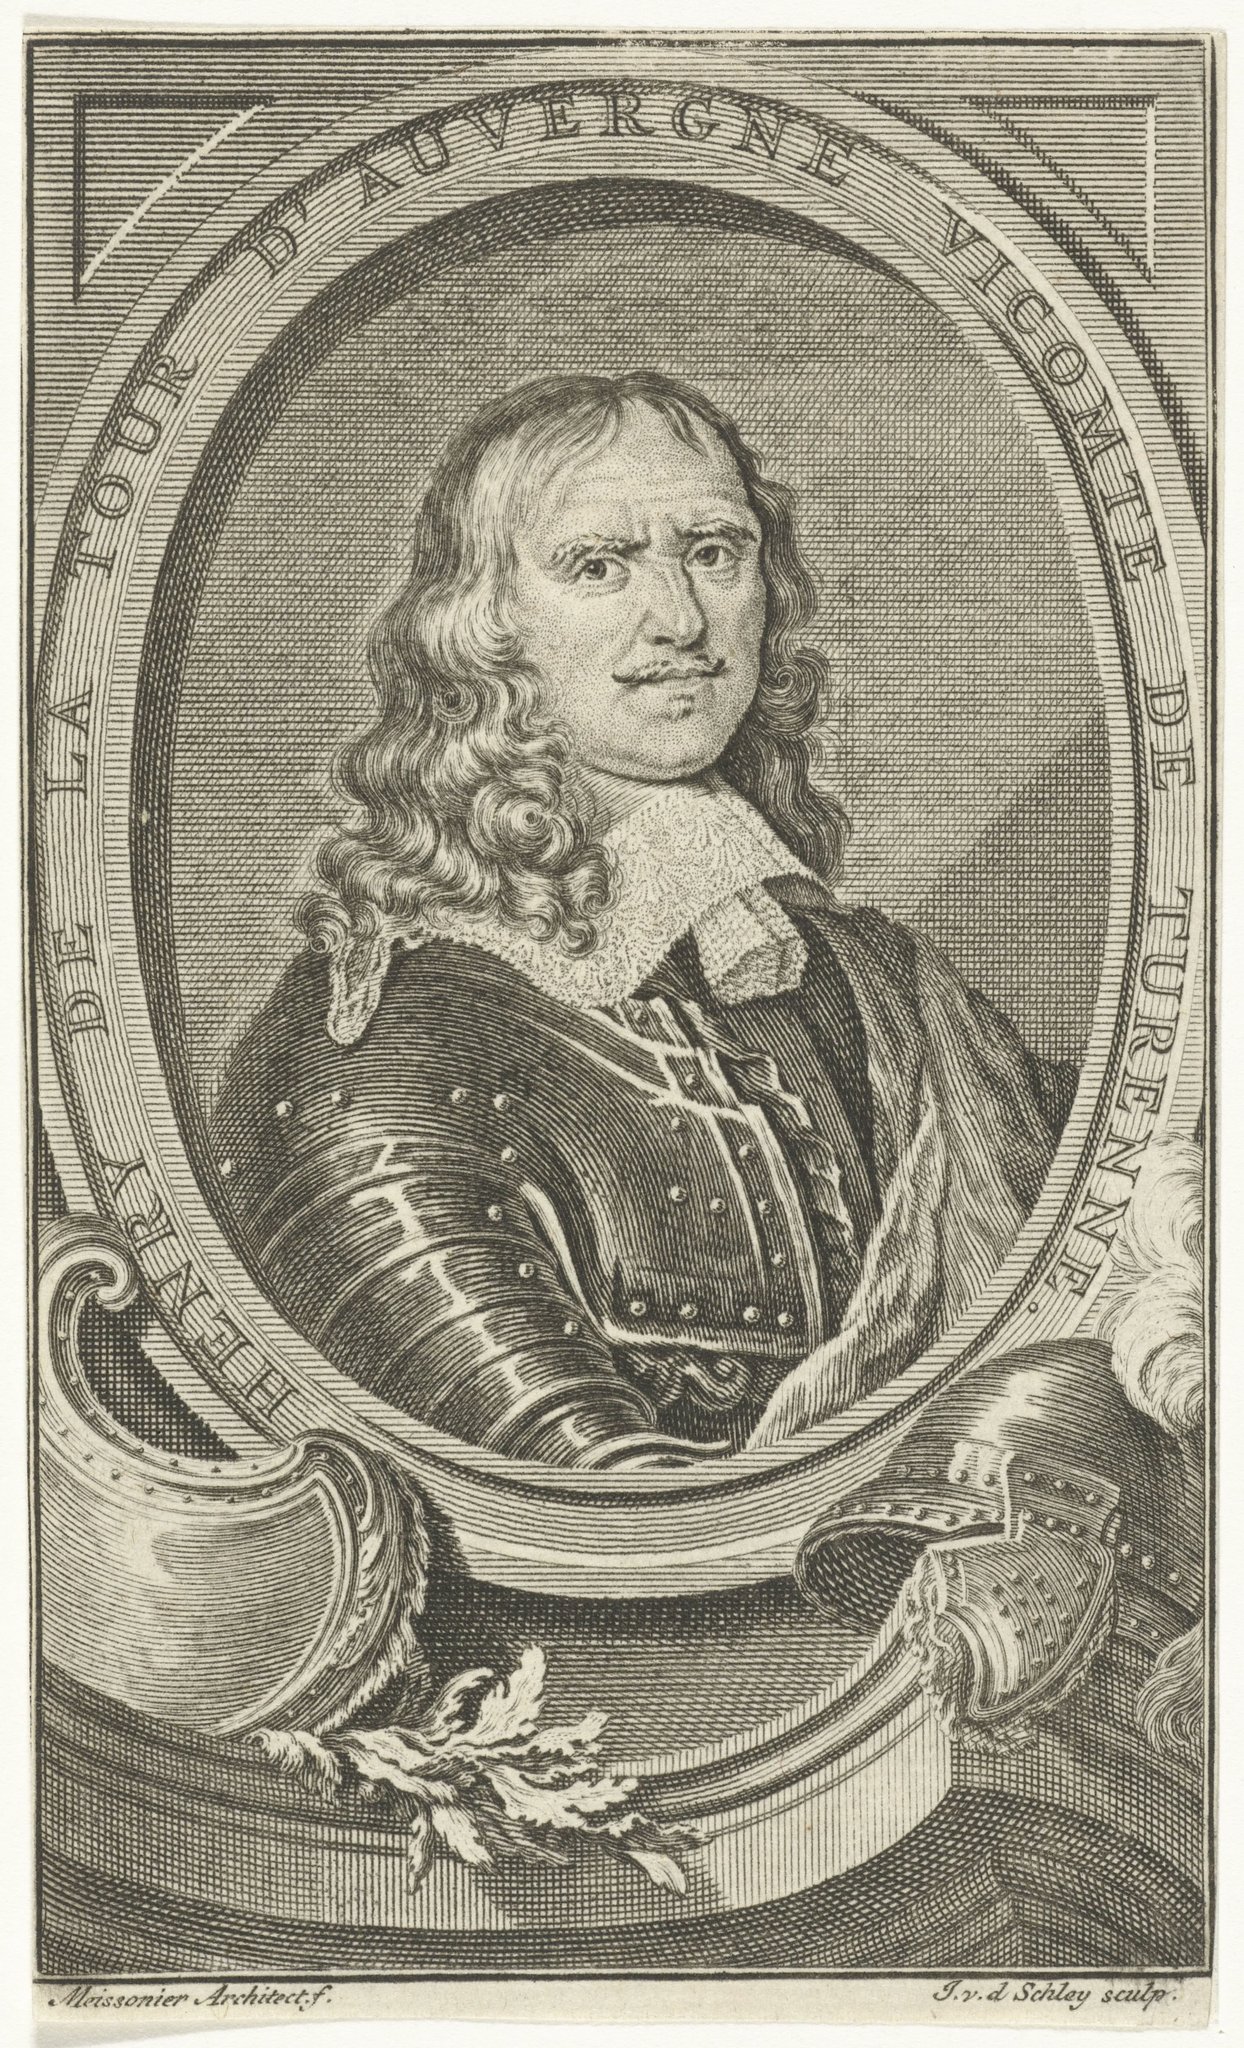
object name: print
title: Portret van Hendrik de la Tour d'Auvergne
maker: jacob van der schley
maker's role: draughtsman, print maker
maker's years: 1715-1779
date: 1725-1779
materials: paper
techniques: engraving, etching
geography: amsterdam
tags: armour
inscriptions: collector's mark: Lugt 2228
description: Portret van Hendrik de la Tour d'Auvergne, burggraaf van Turenne. Hij draagt een harnas.